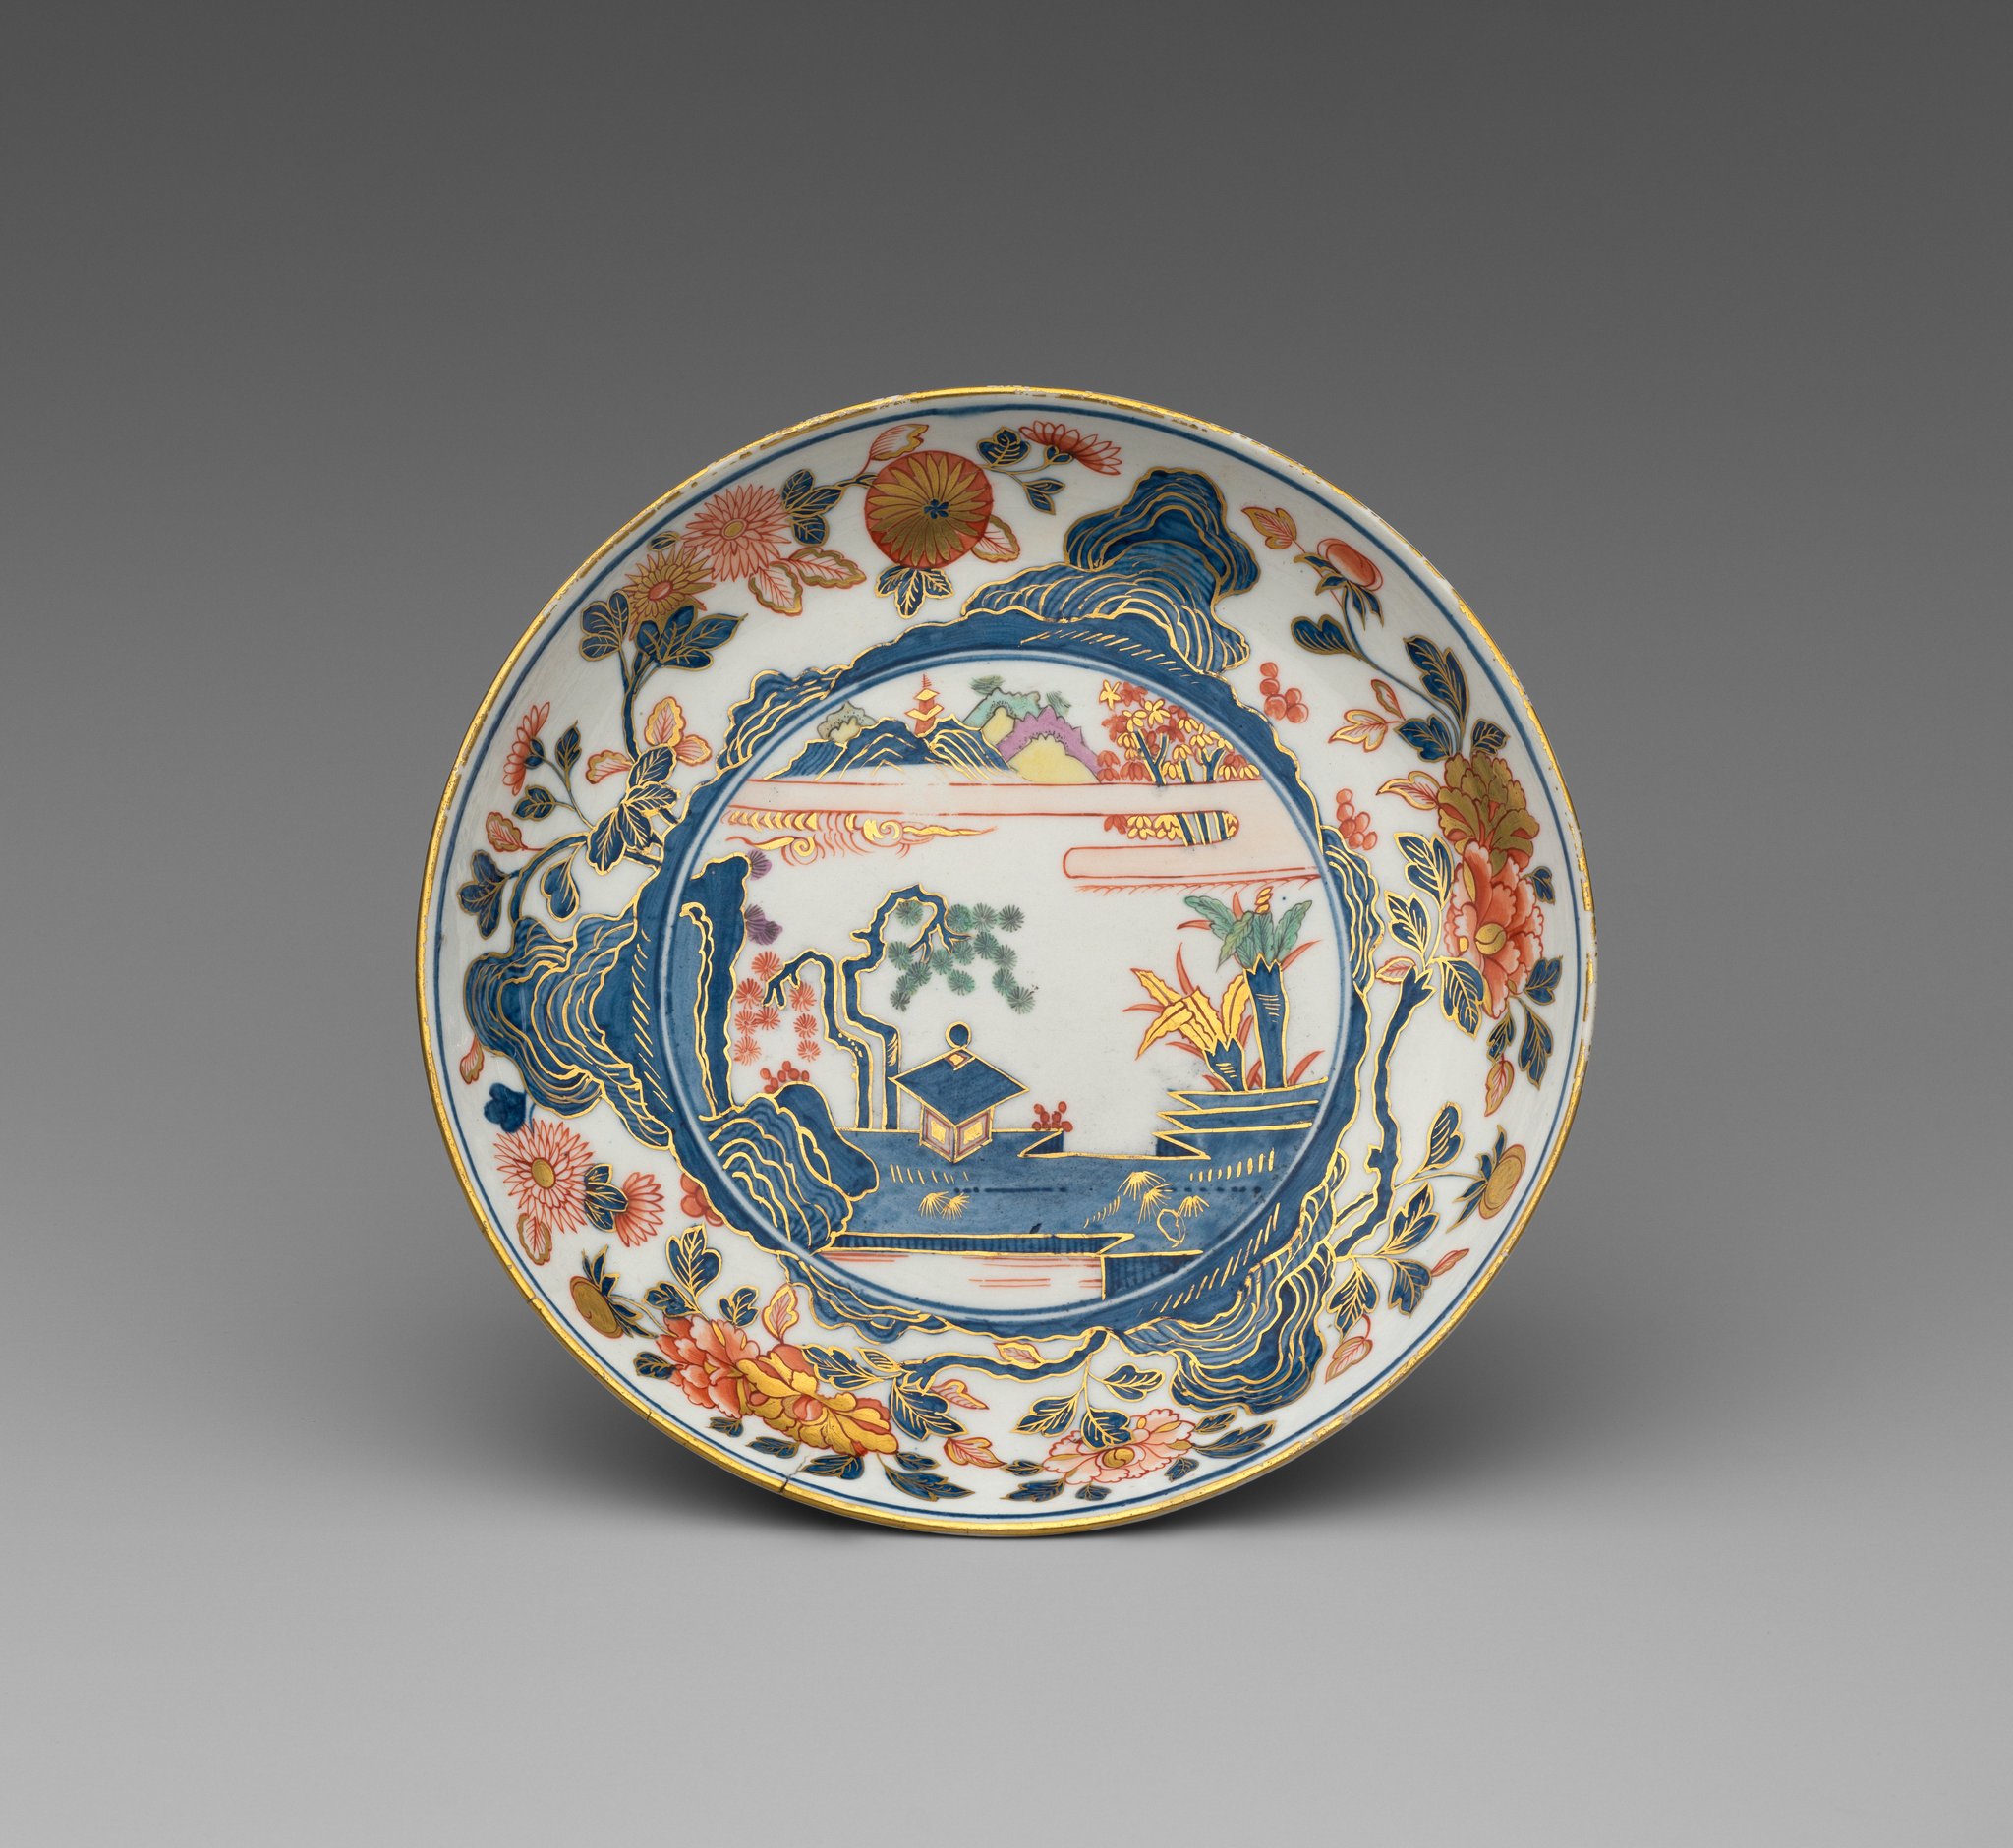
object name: plate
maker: worcester factory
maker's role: factory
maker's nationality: british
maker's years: 1751-2008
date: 1770-1775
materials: soft paste porcelain